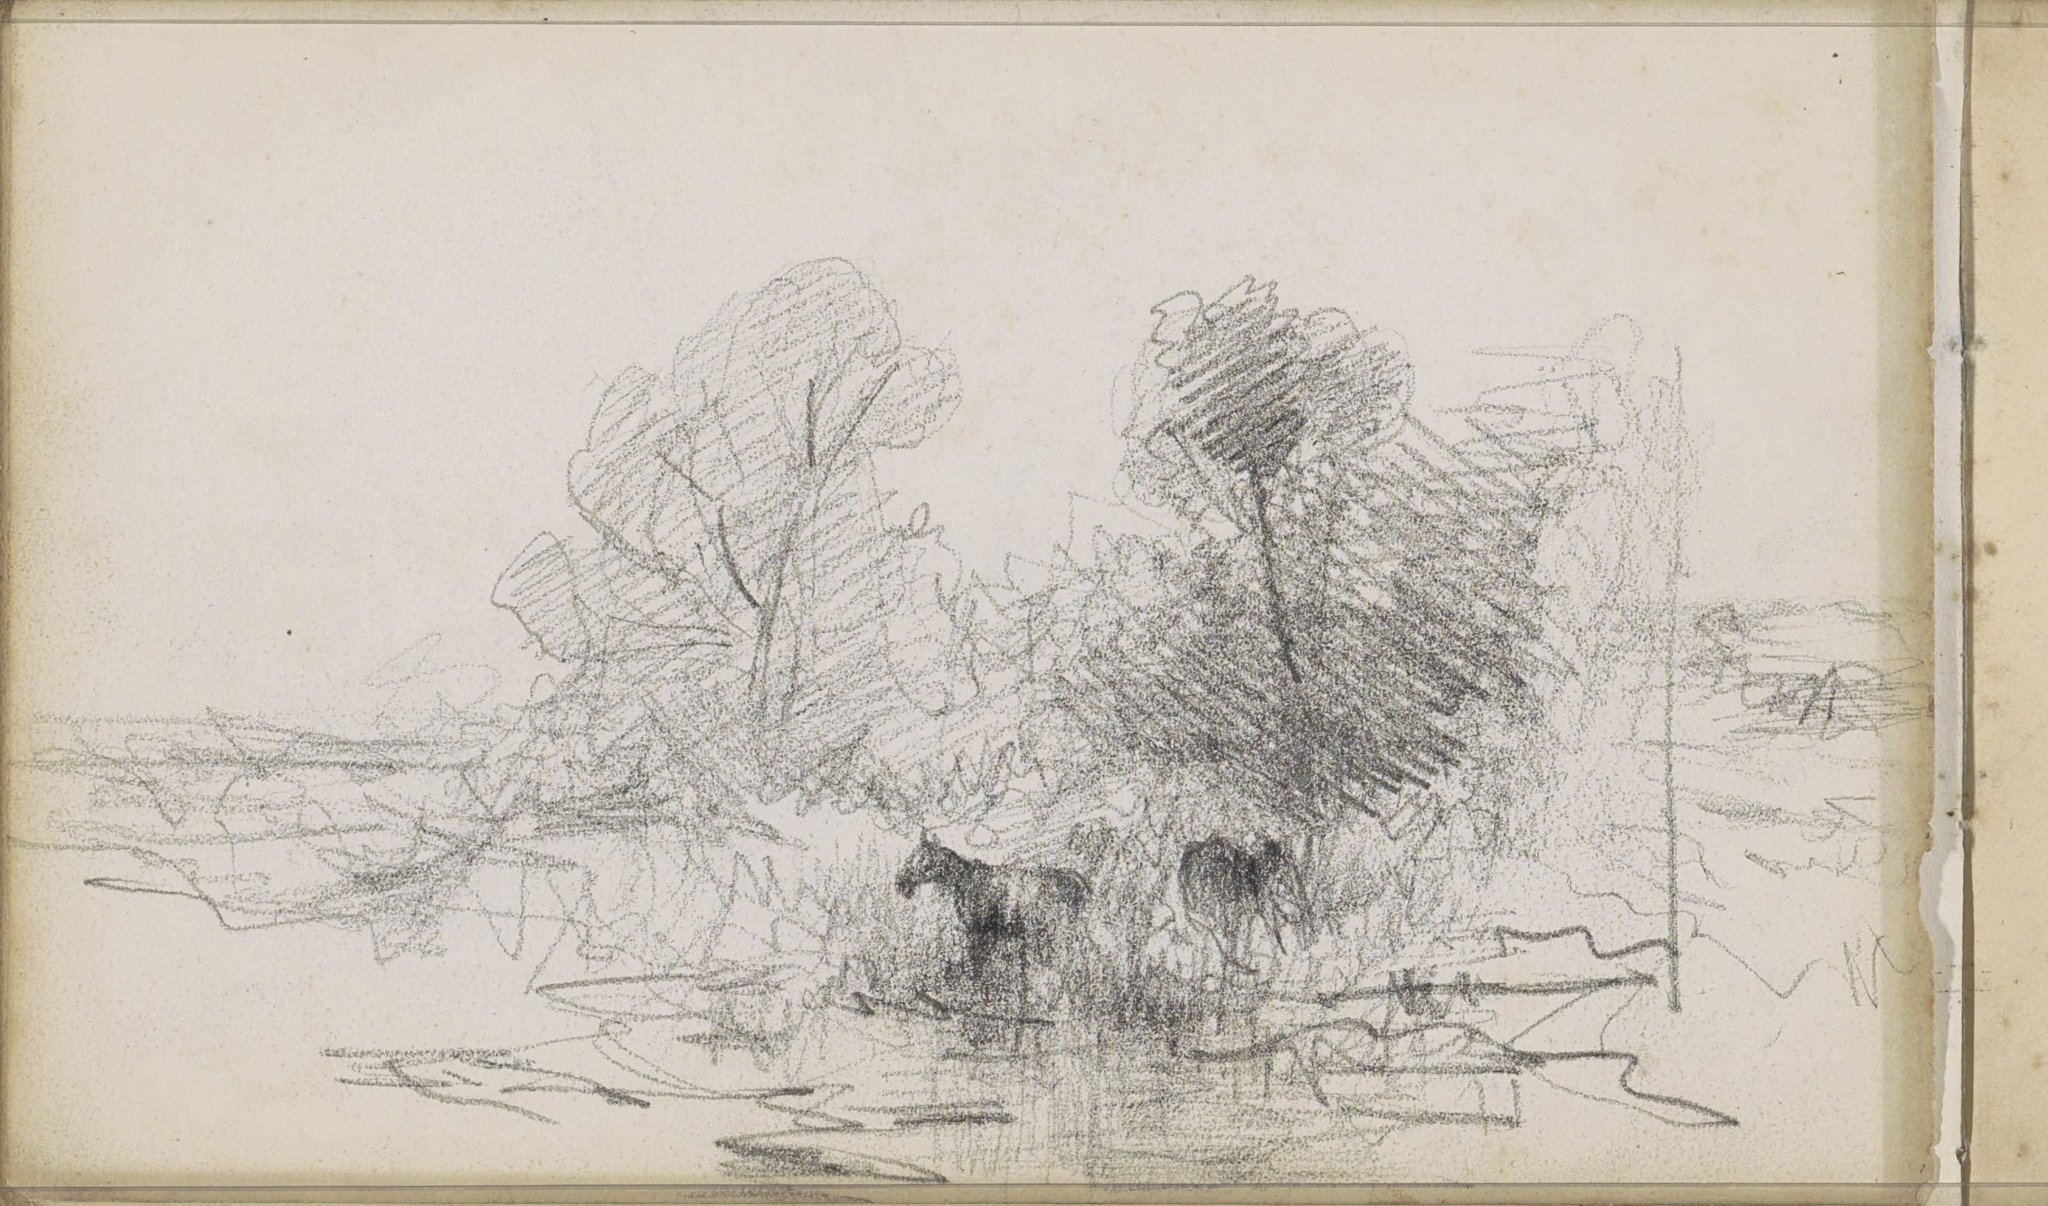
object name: sketchbook leaf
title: Paarden aan een waterkant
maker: willem cornelis rip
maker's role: draughtsman, painter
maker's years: 1856-1922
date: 1874-1875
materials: paper, pencil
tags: landscapes with waters, waterscapes, seascapes (in the temperate zone), horse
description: Blad 39 verso uit een schetsboek met 46 bladen.